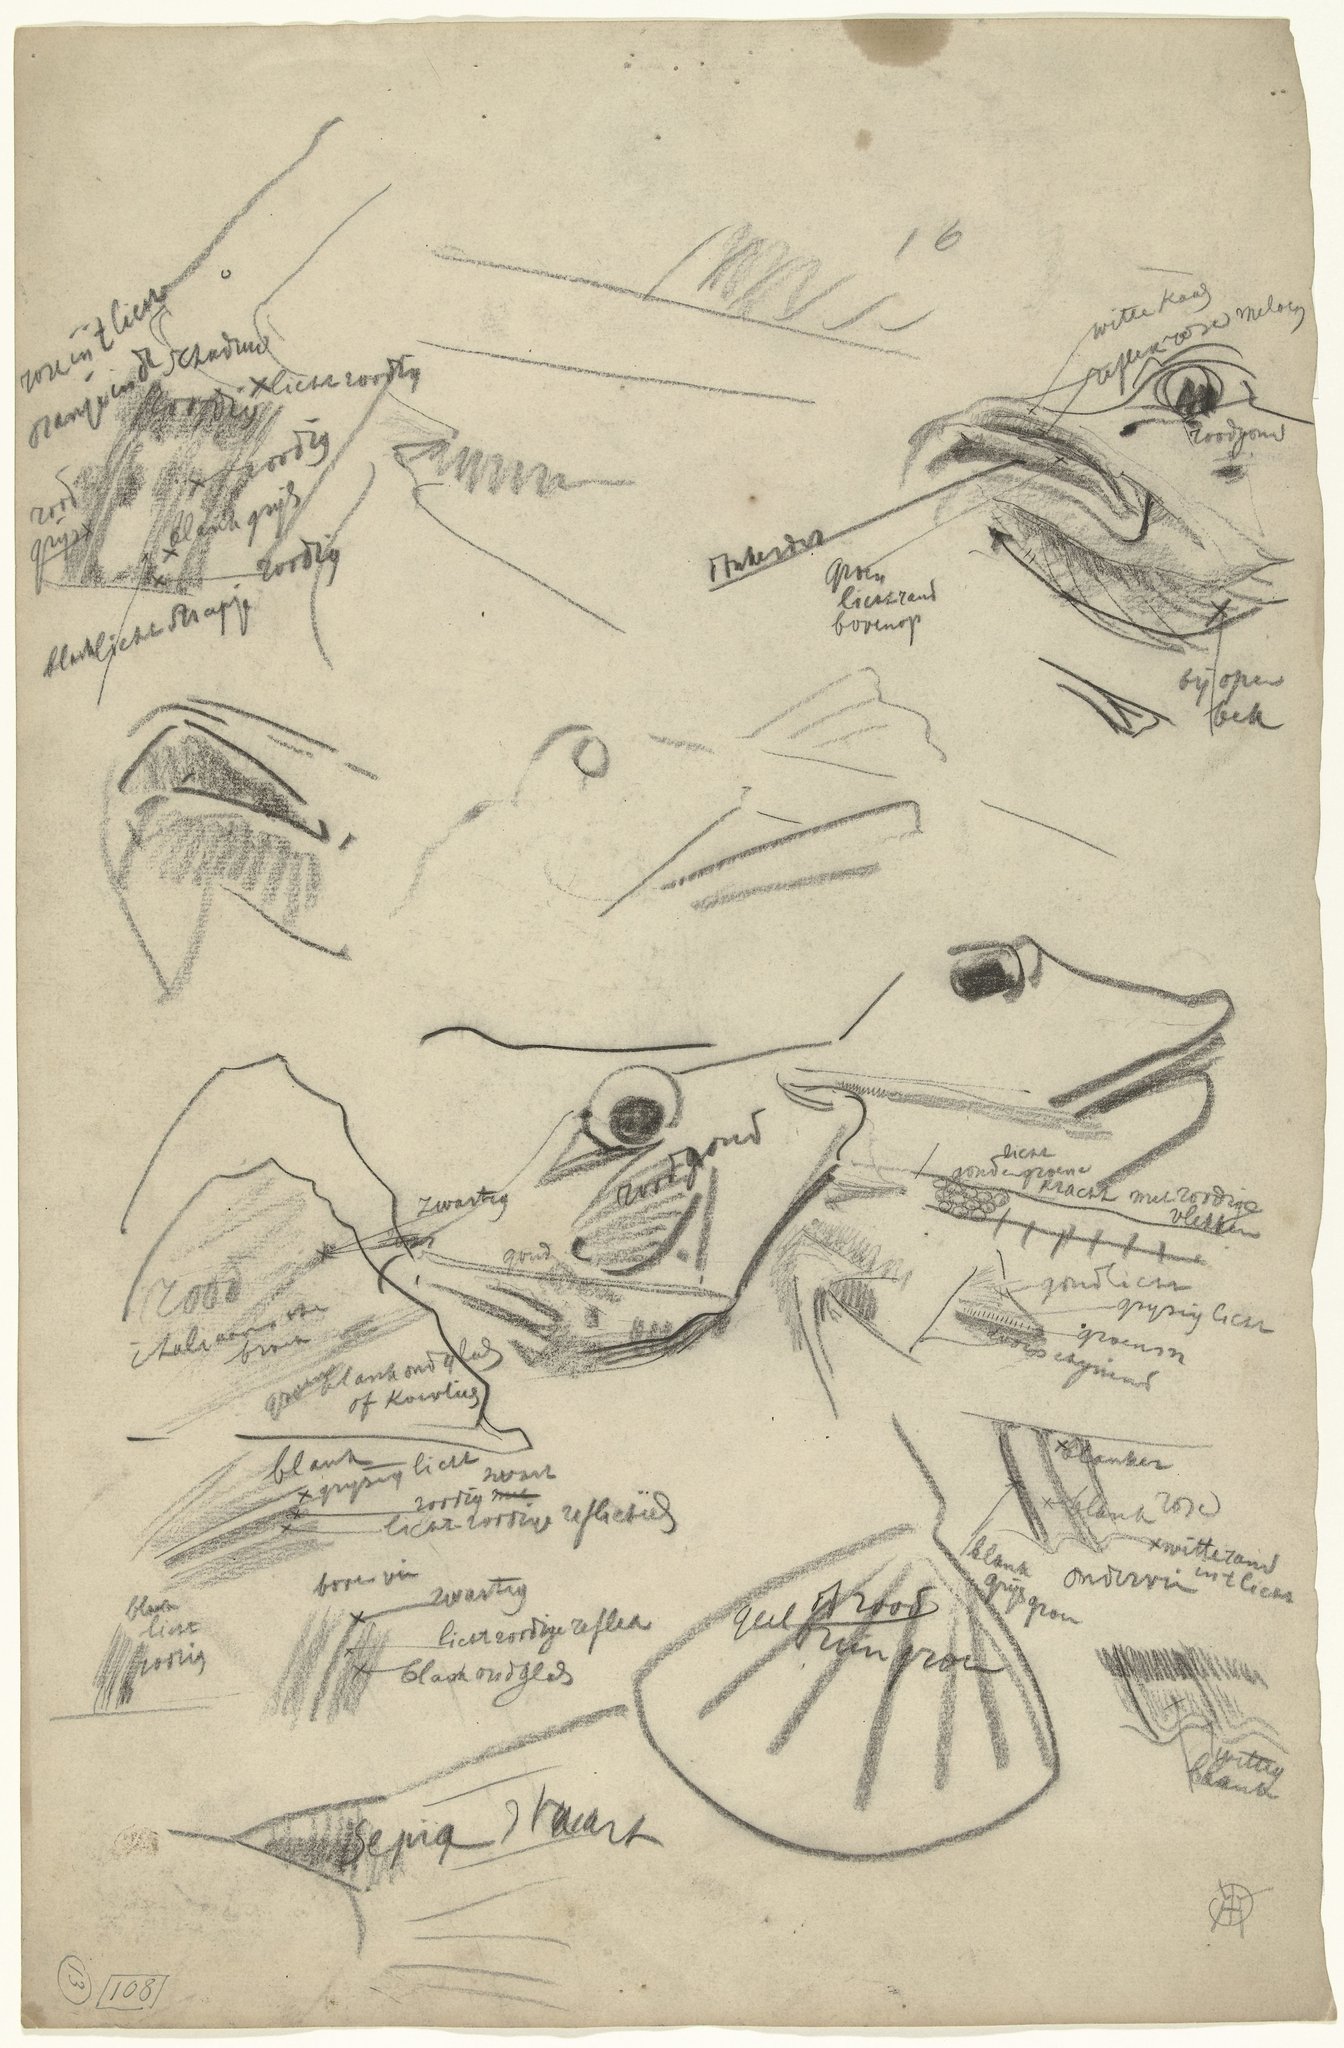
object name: drawing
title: Detailstudies van een poon, met kleurnotities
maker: gerrit willem dijsselhof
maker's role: designer, draughtsman, print maker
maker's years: 1866-1924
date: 1876-1924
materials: chalk, paper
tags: bony fishes: gurnard